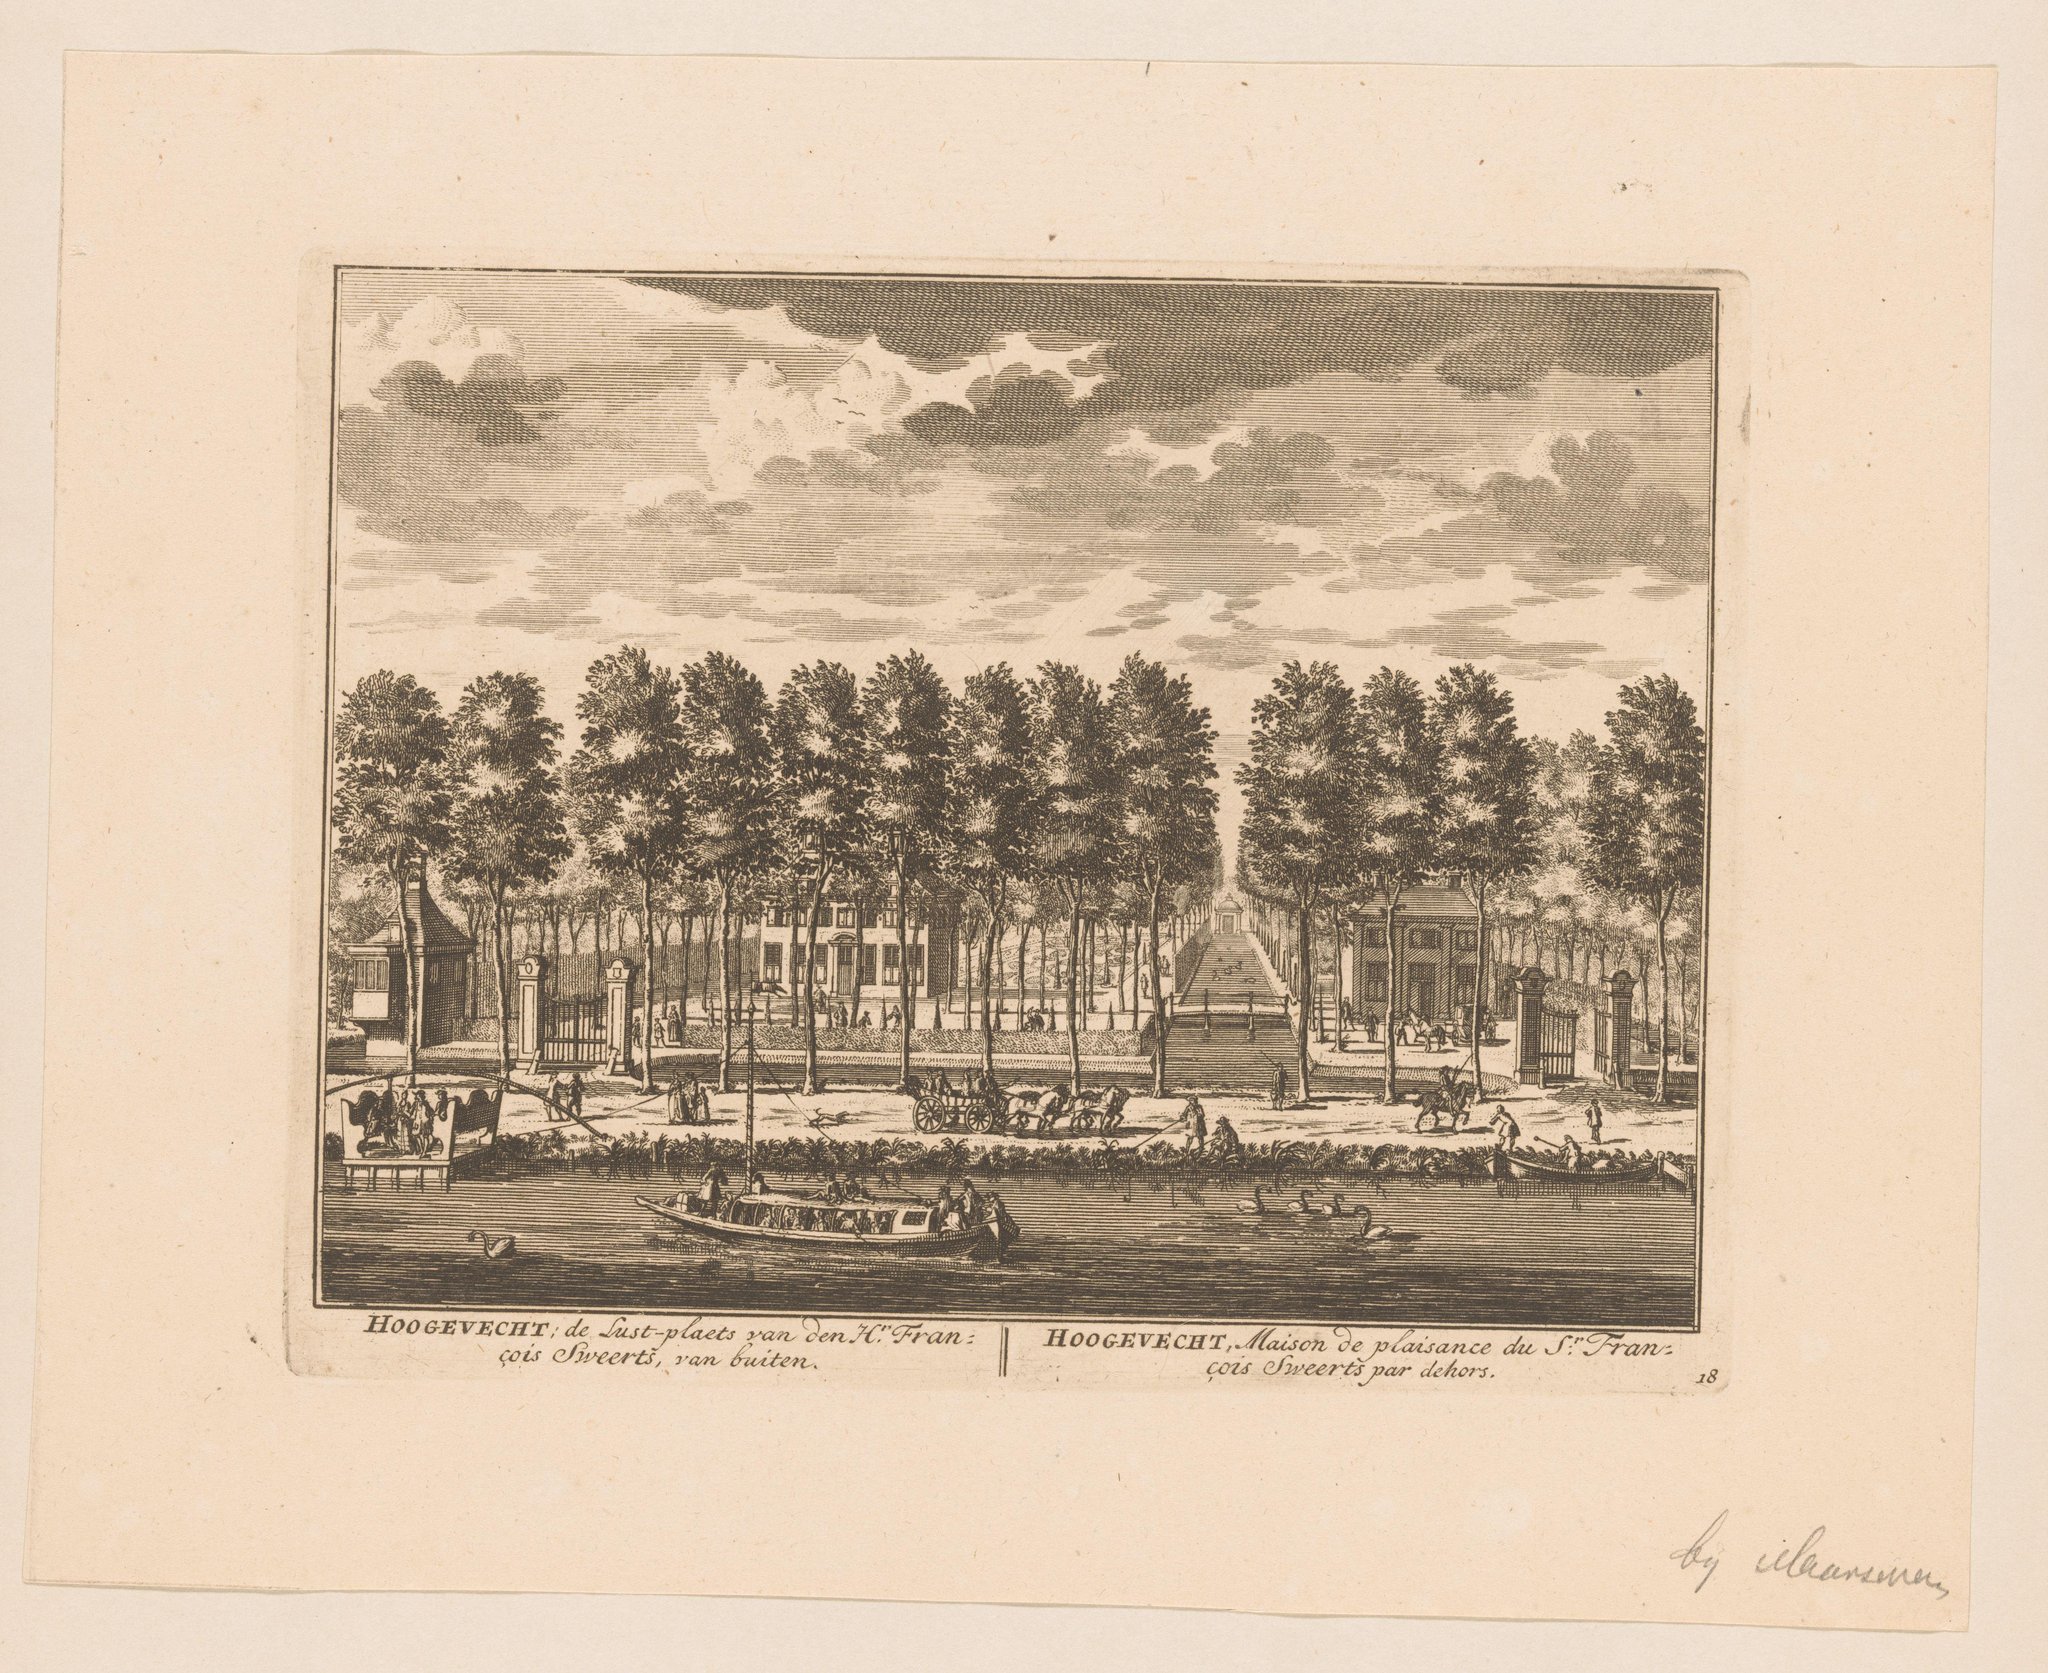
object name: print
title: Gezicht op de buitenplaats Hoogevecht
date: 1719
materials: paper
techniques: etching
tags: river, rural housing, e.g. country-house, villa, cottage, maarssen, vecht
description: Prent uit: De zegepraalende Vecht, vertoonende verscheidene gesichten van lustplaatsen, heeren huysen en dorpen, beginnende van Uitrecht en met Muyden besluytende. Amsterdam: Wed. Nicolaes Visscher, 1719.